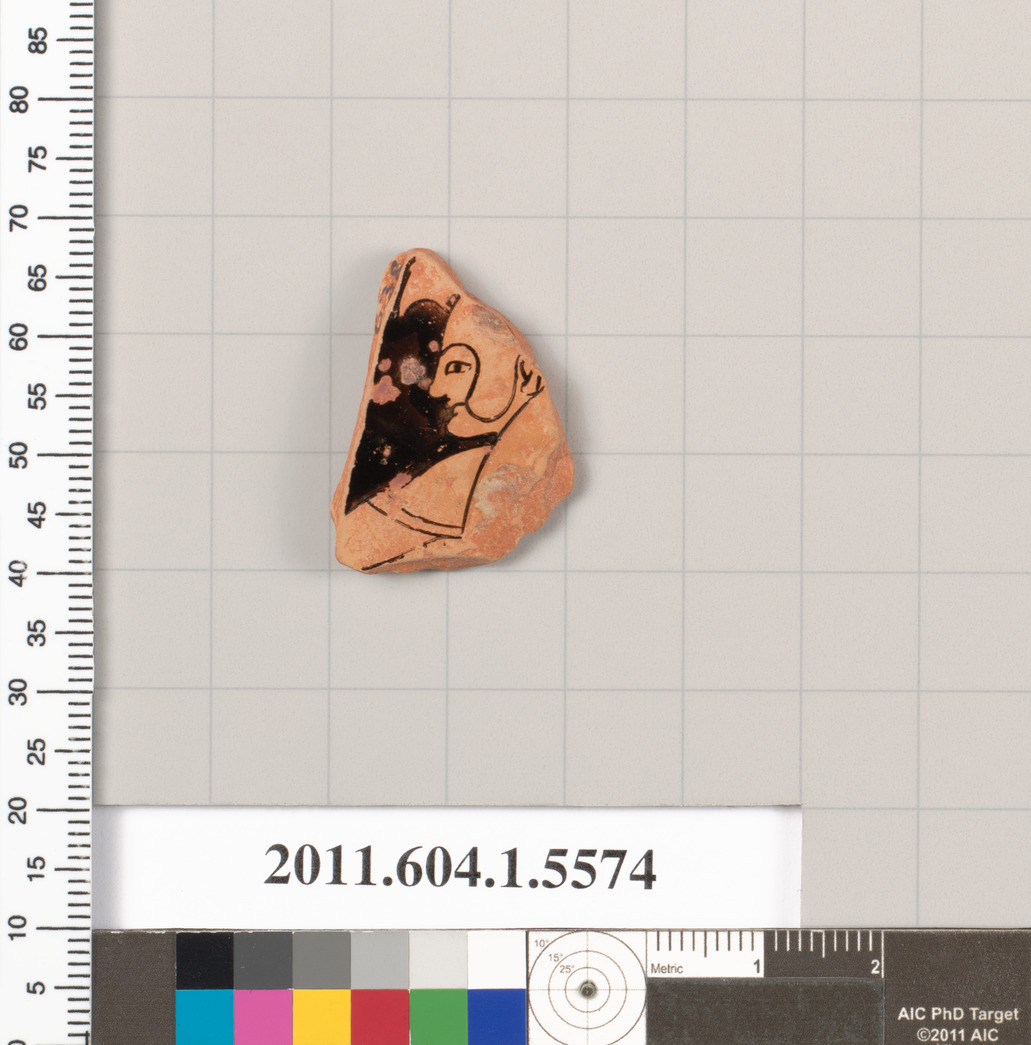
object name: kylix fragment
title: Terracotta fragment of a kylix (drinking cup)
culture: greek, attic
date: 520-510 BCE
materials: terracotta